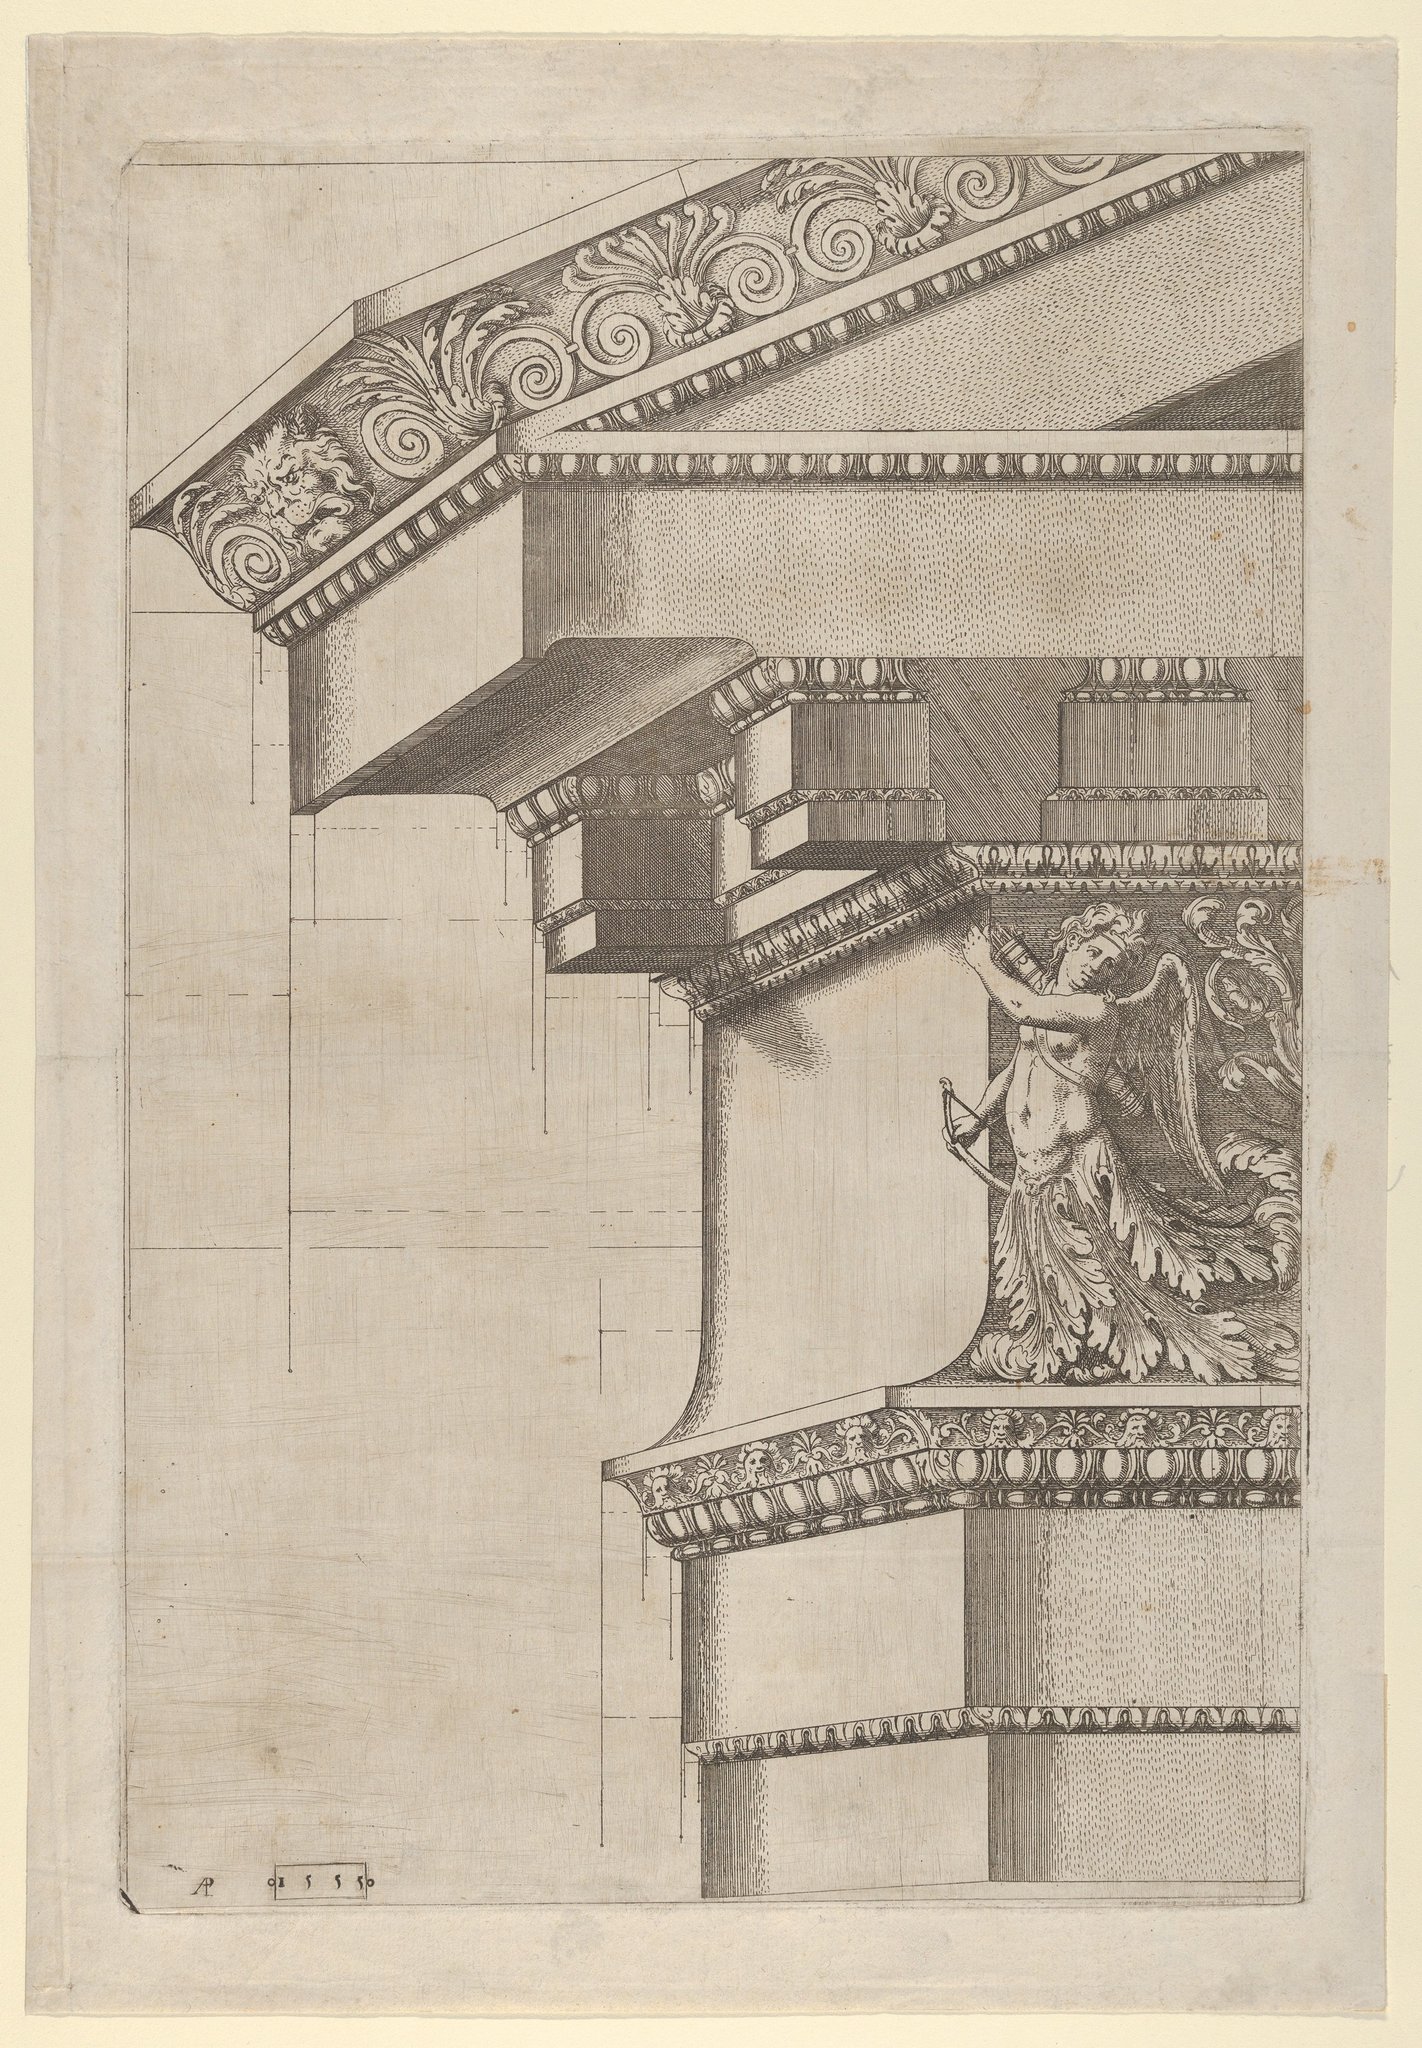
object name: print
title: Temple of Serapis, pediment and cornice, projection view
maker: master ap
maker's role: artist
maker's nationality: french or italian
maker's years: 1555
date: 1555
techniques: etching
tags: bow and arrow